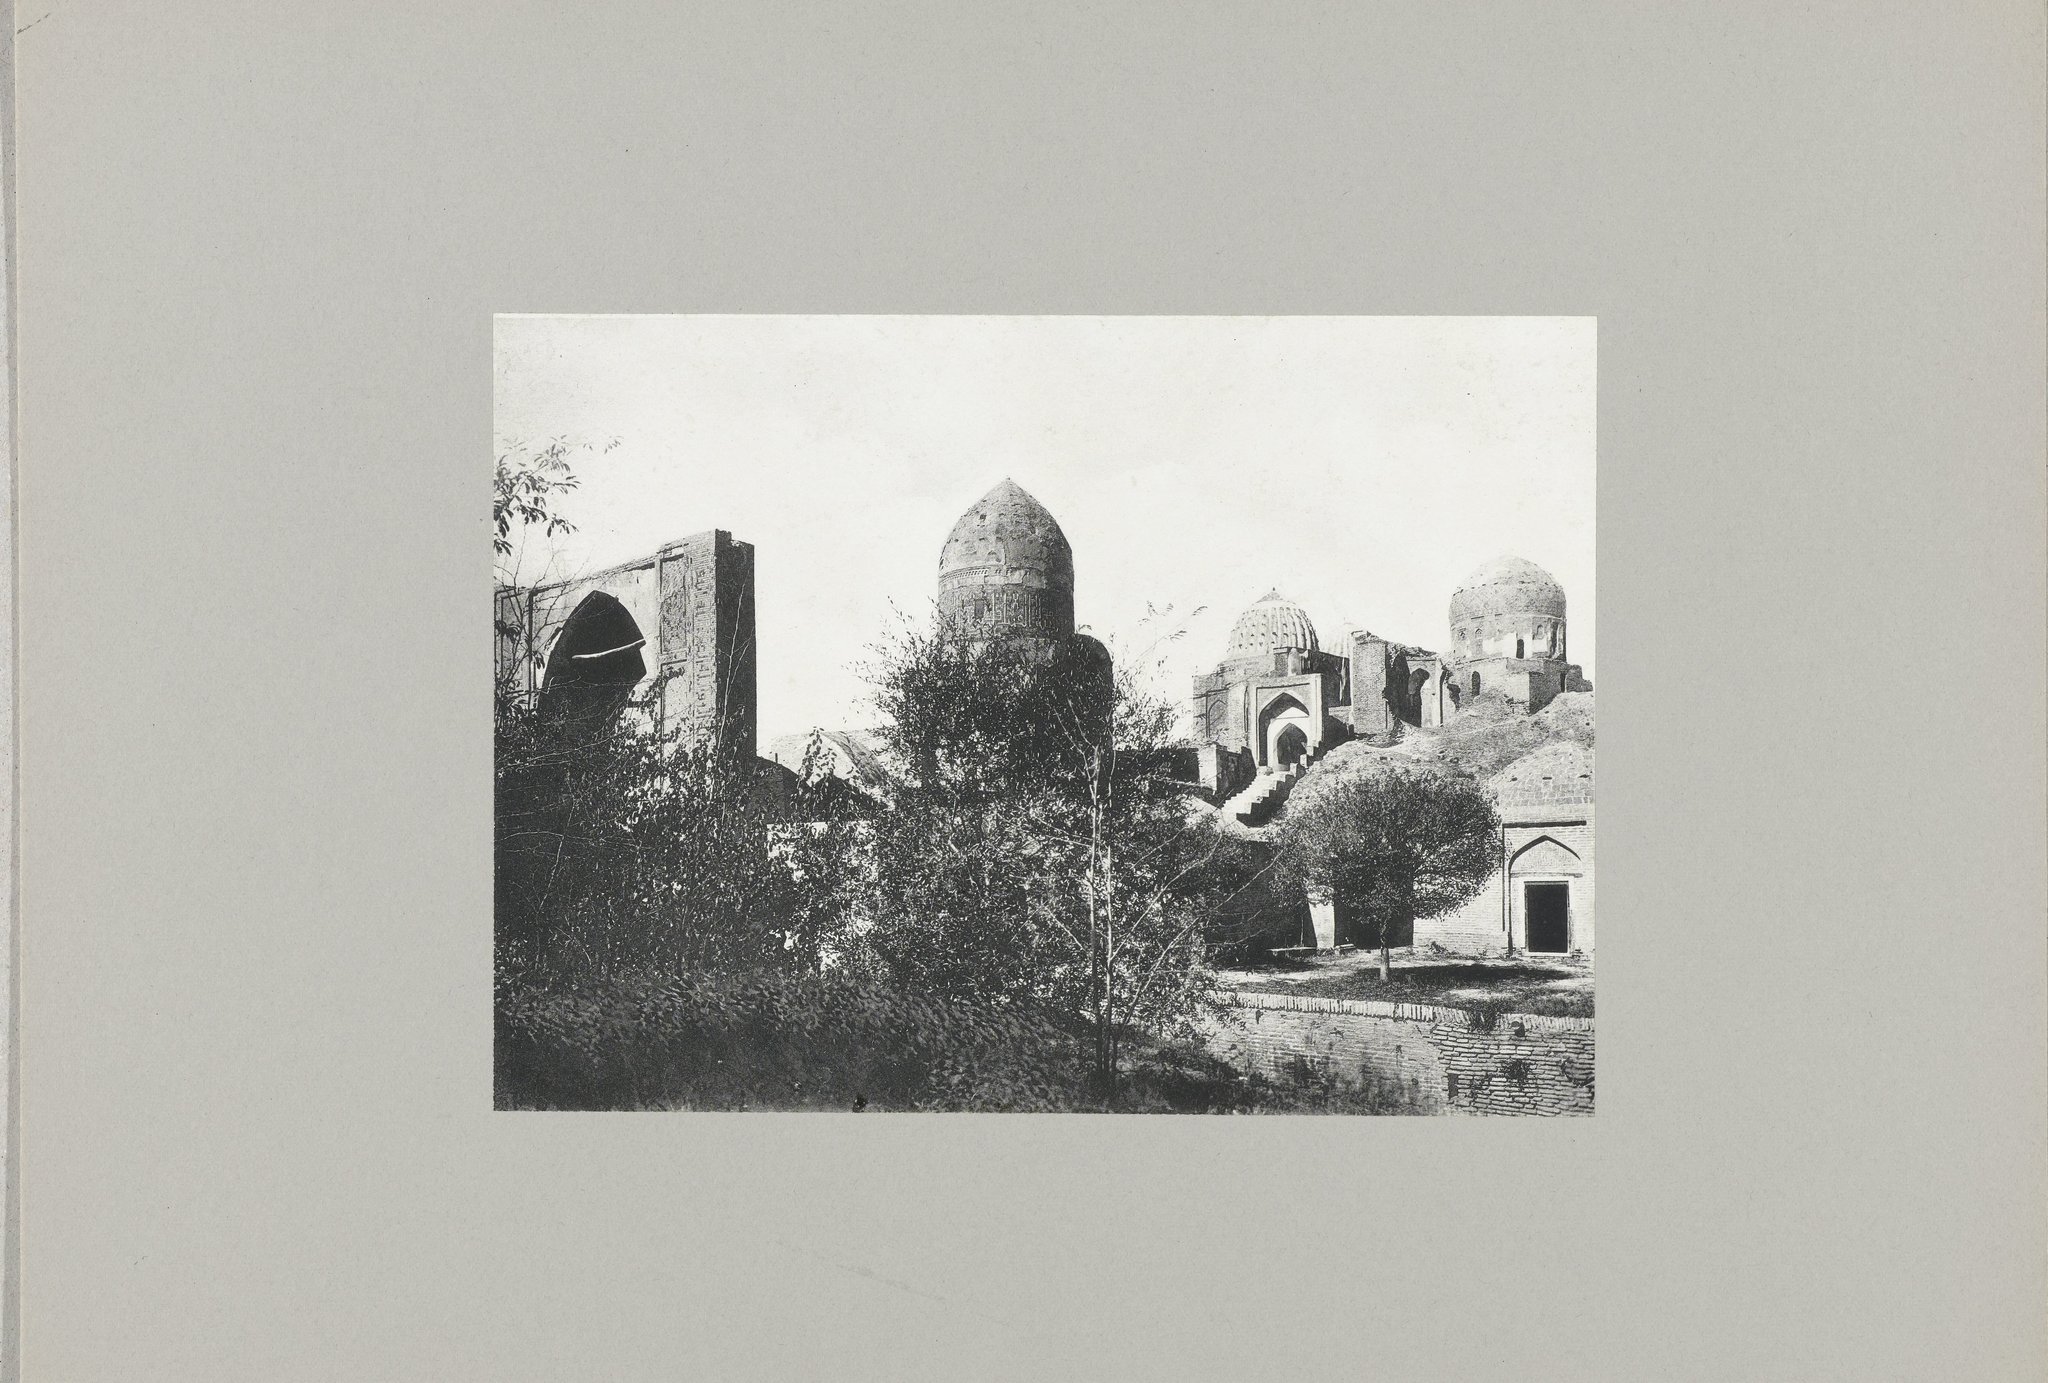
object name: photomechanical print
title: Groep van mausoleums te Samarkand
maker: Anonymous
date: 1895-1915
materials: cardboard, paper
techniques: photograph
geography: samarqand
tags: samarqand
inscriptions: annotation: ‘12. Groep van Mausoleums te Samarkand.’